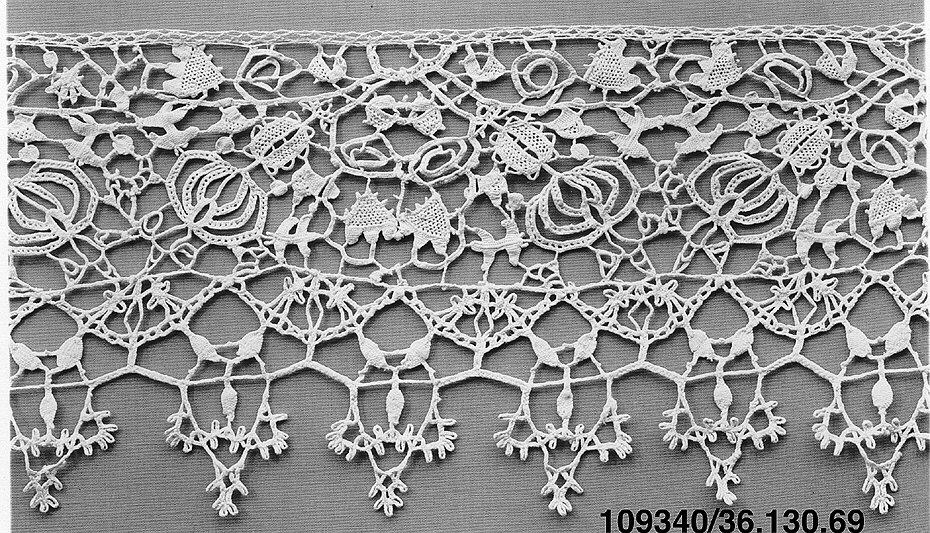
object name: border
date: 1601-1700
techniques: lace